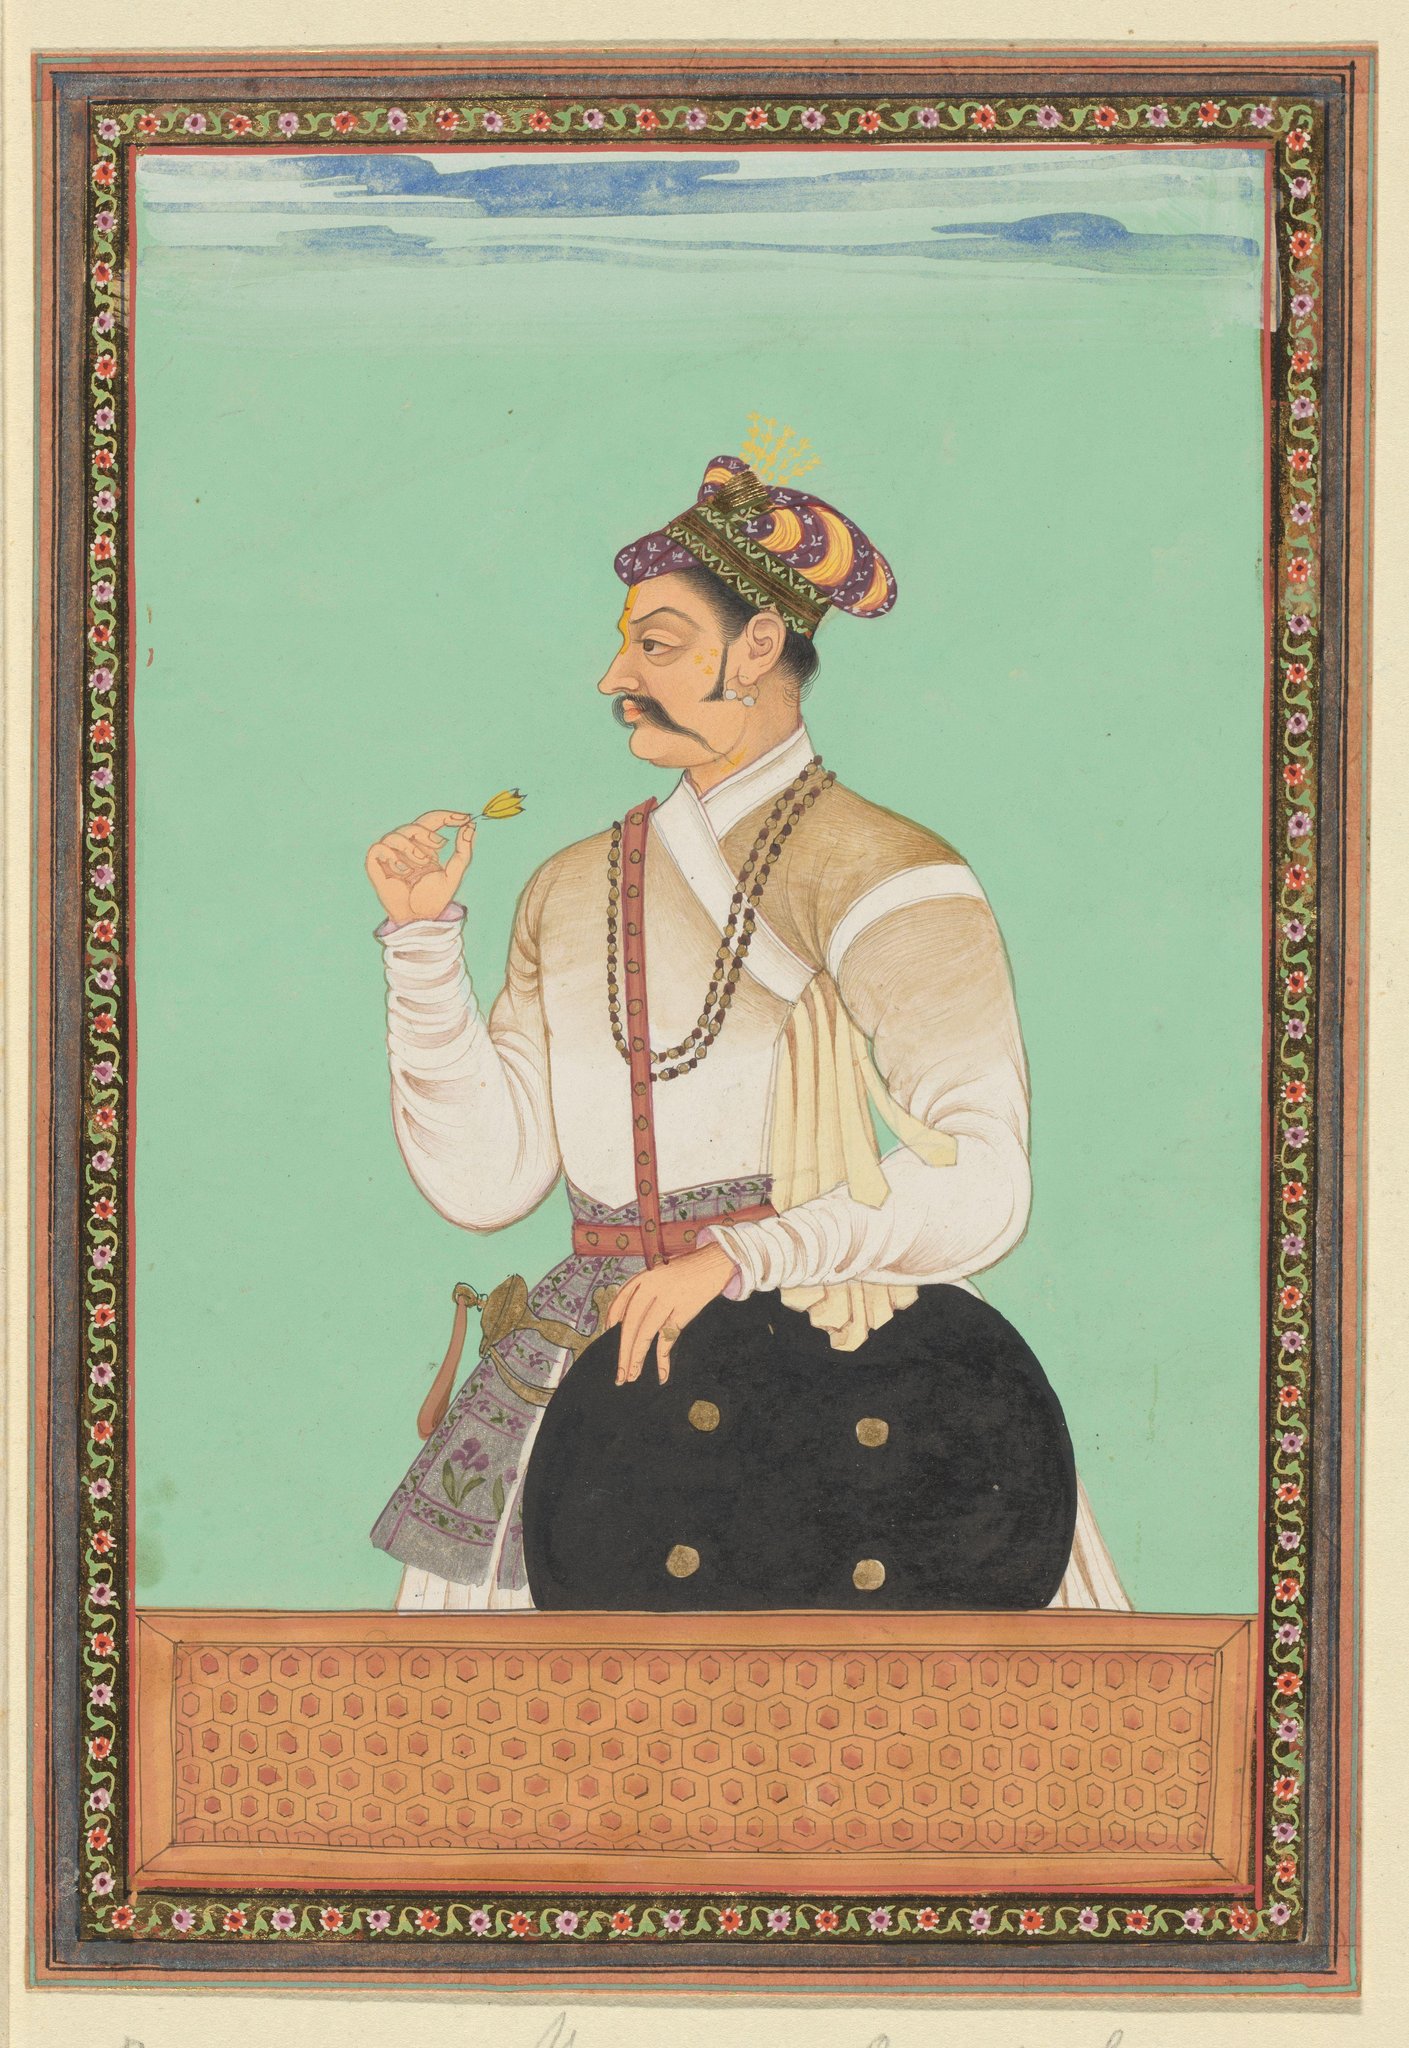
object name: indian miniature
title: Portret van Raja Karan, die vizier van Aurangzeb is geweest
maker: Anonymous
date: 1686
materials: paint, gold leaf, gouache, paper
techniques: brush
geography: golkonda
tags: amsterdam, print maker, nicolaes cornelisz. witsen, historical person (...) - historical person (...) portrayed alone, ruler, sovereign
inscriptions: annotation: ‘Ragiak Juran Visir van Orangh Sieb, ook genaamd Ragia Kjeran’, collector's mark: Lugt 1838, collector's mark: Lugt 240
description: Raja Karan is tot aan zijn heupen afgebeeld, naar links gewend, in zijn rechter hand een bloem, zijn linker hand rust op een schild. Blad 16 in het `Witsen-Album', met 49 Indiase miniaturen van vorsten. Boven het portret een stukje papier met de naam in het Perzisch. Onder het portret een stukje papier met de naam in het Portugees.